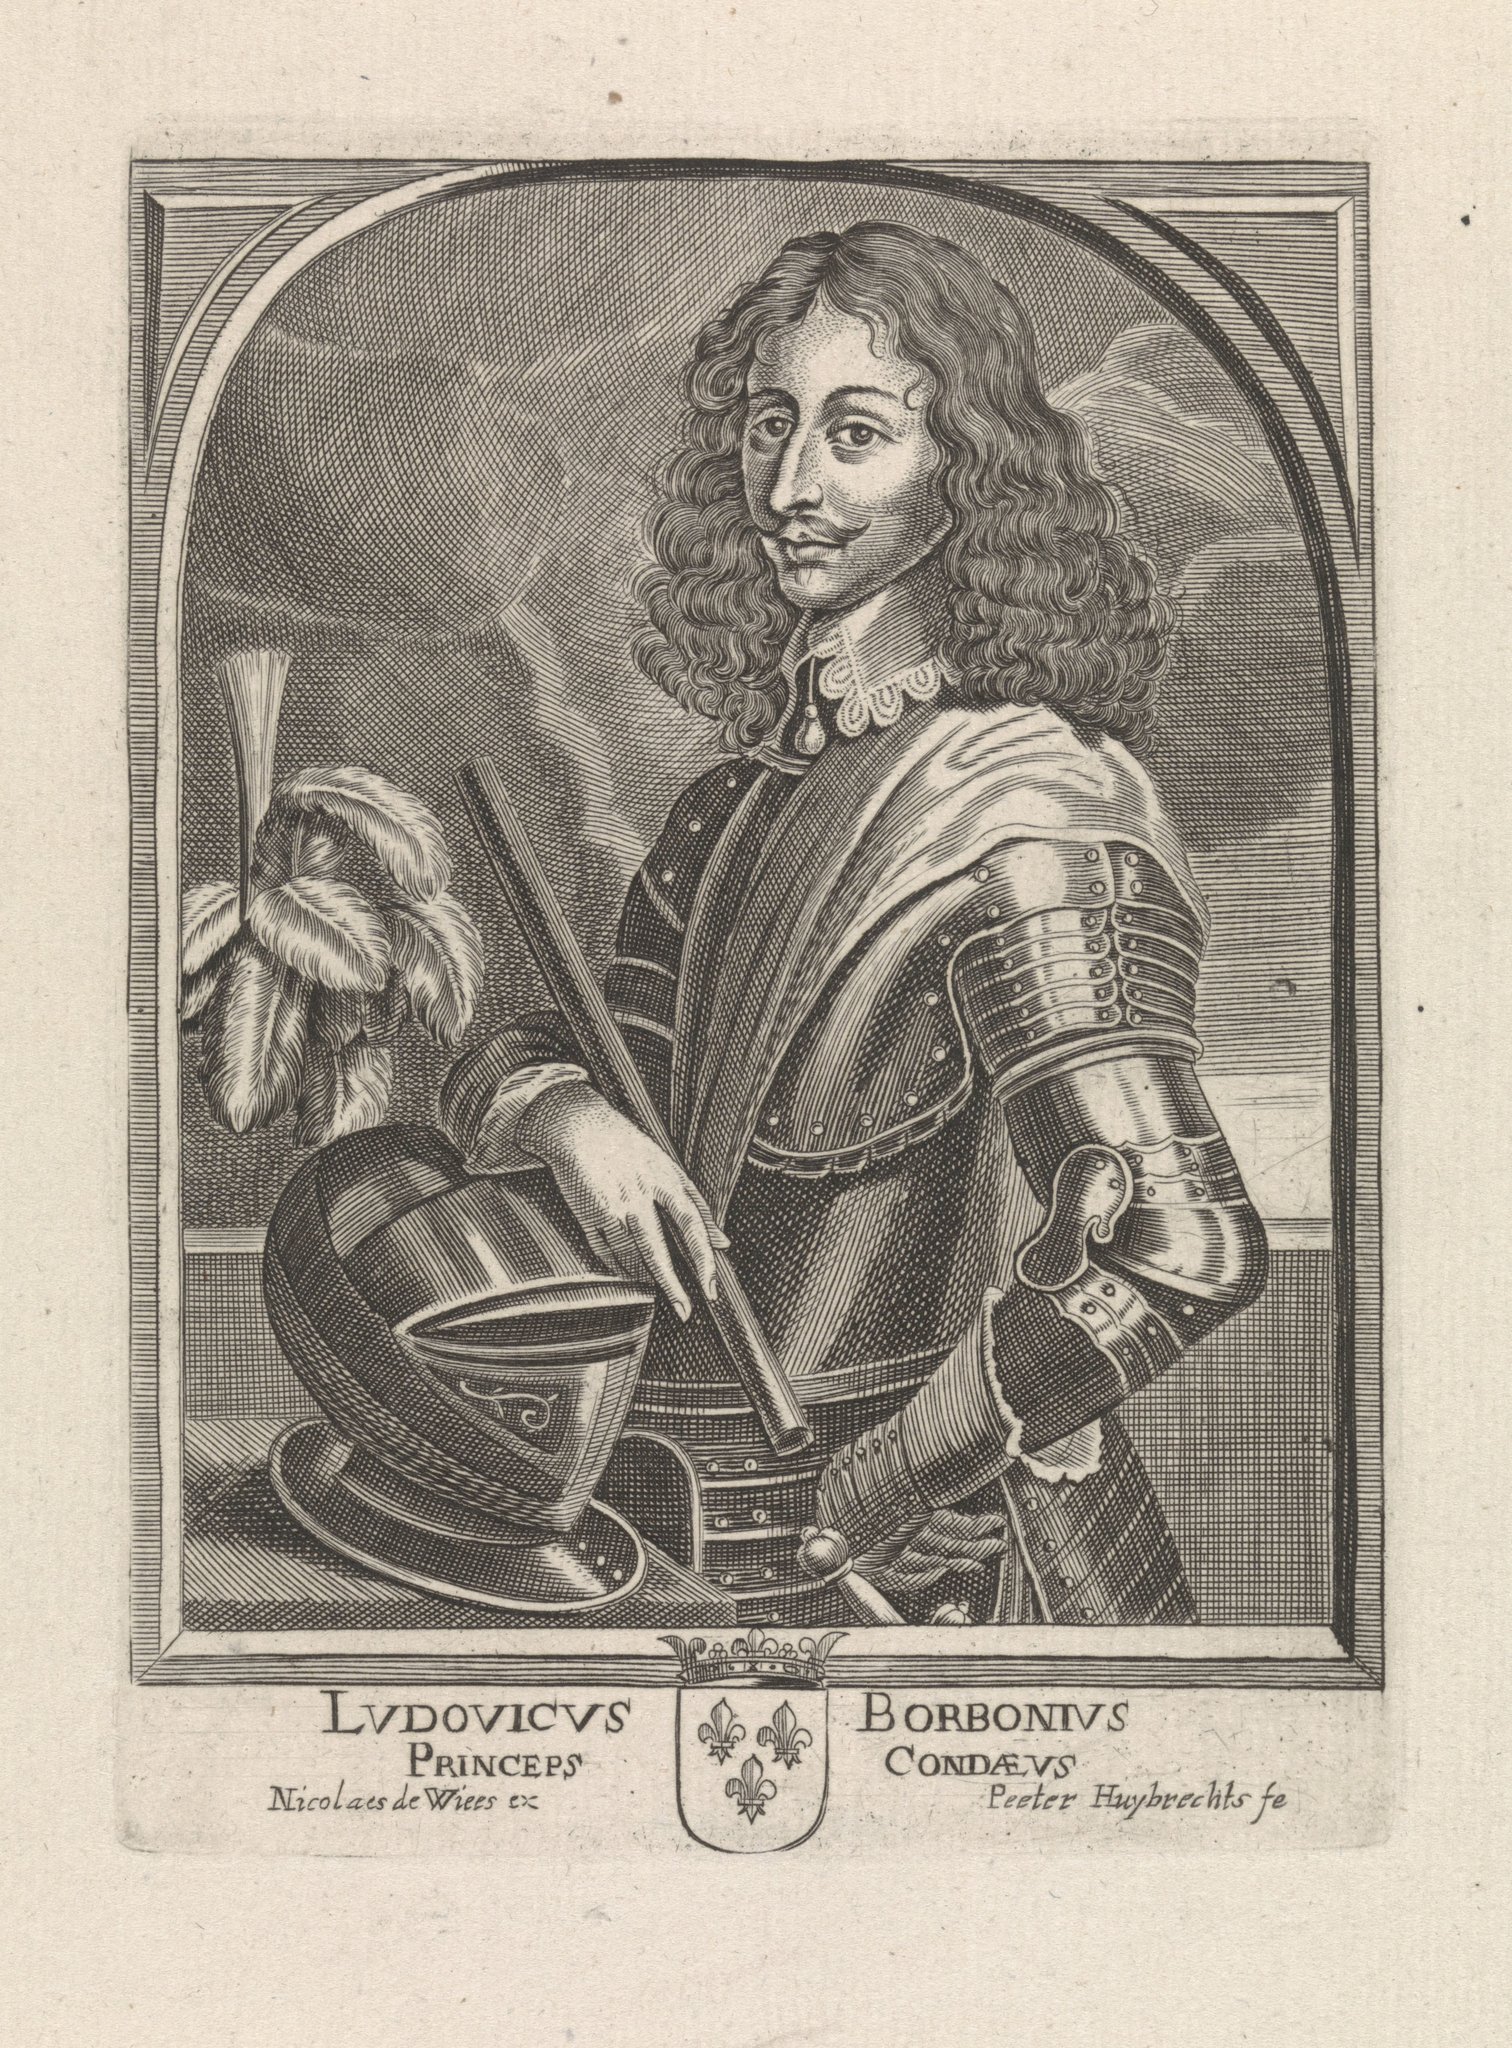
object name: print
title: Portret van Lodewijk II van Bourbon-Condé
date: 1635-1653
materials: paper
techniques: engraving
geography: antwerp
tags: lodewijk ii de bourbon-condé (hertog van enghien)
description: Lodewijk II van Bourbon-Condé ten halven lijve naar links in harnas, zijn rechterarm rustend op zijn helm voor hem. Midden onder zijn familiewapen.